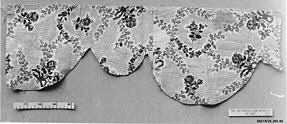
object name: piece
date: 1775-1785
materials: linen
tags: flowers